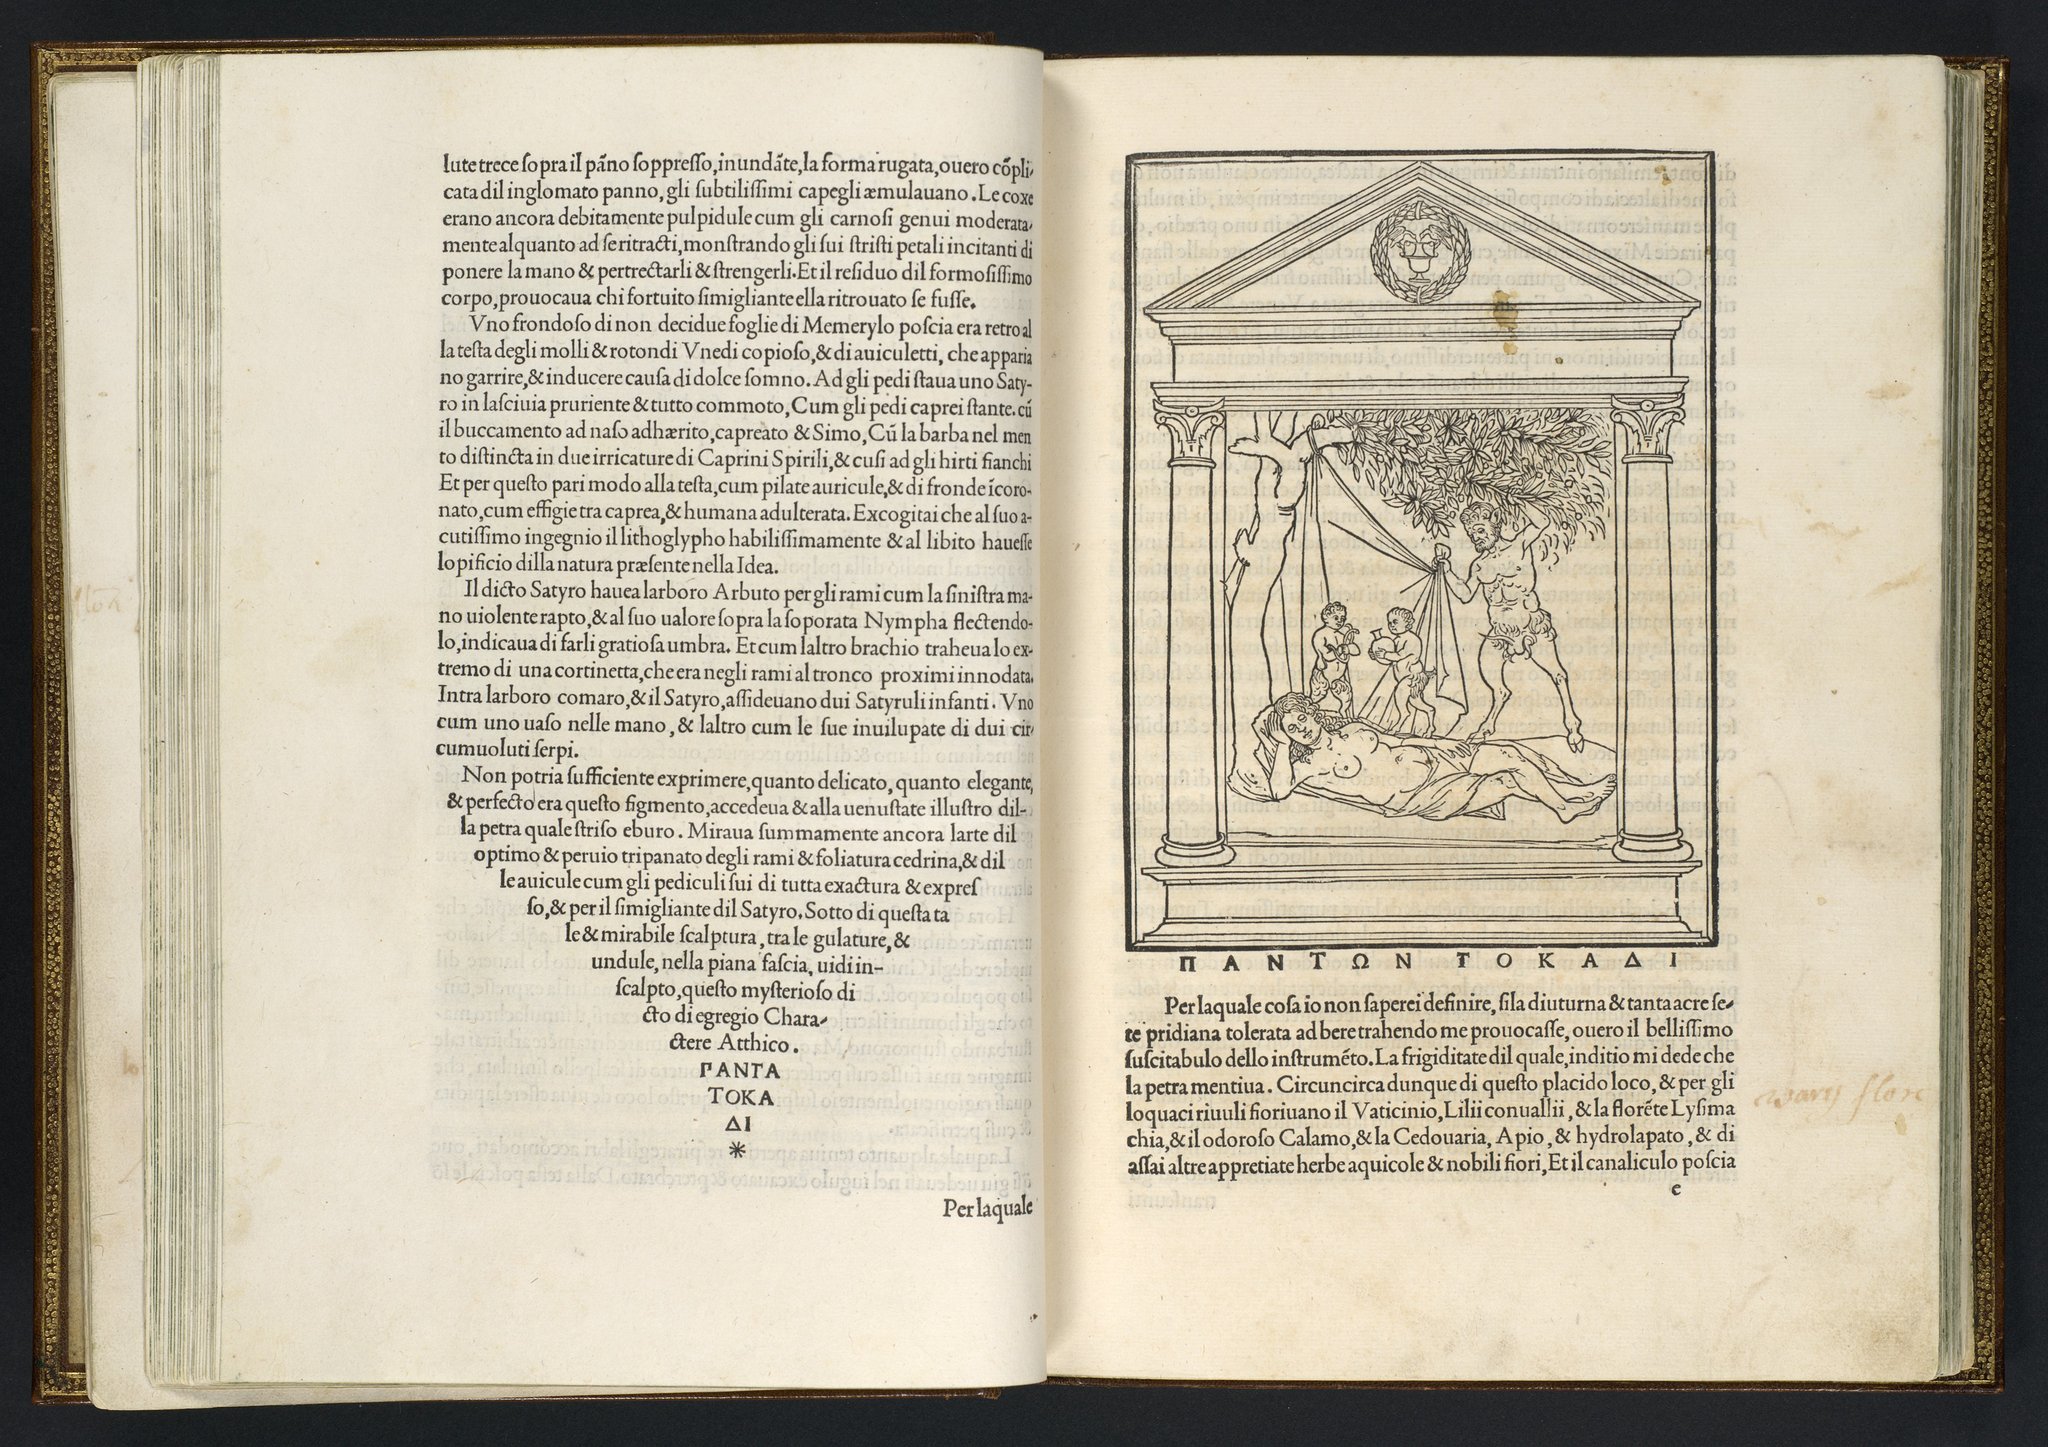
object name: book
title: Hypnerotomachia Poliphili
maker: francesco colonna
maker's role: author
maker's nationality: italian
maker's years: 1453-1517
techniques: printing, woodcut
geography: italy